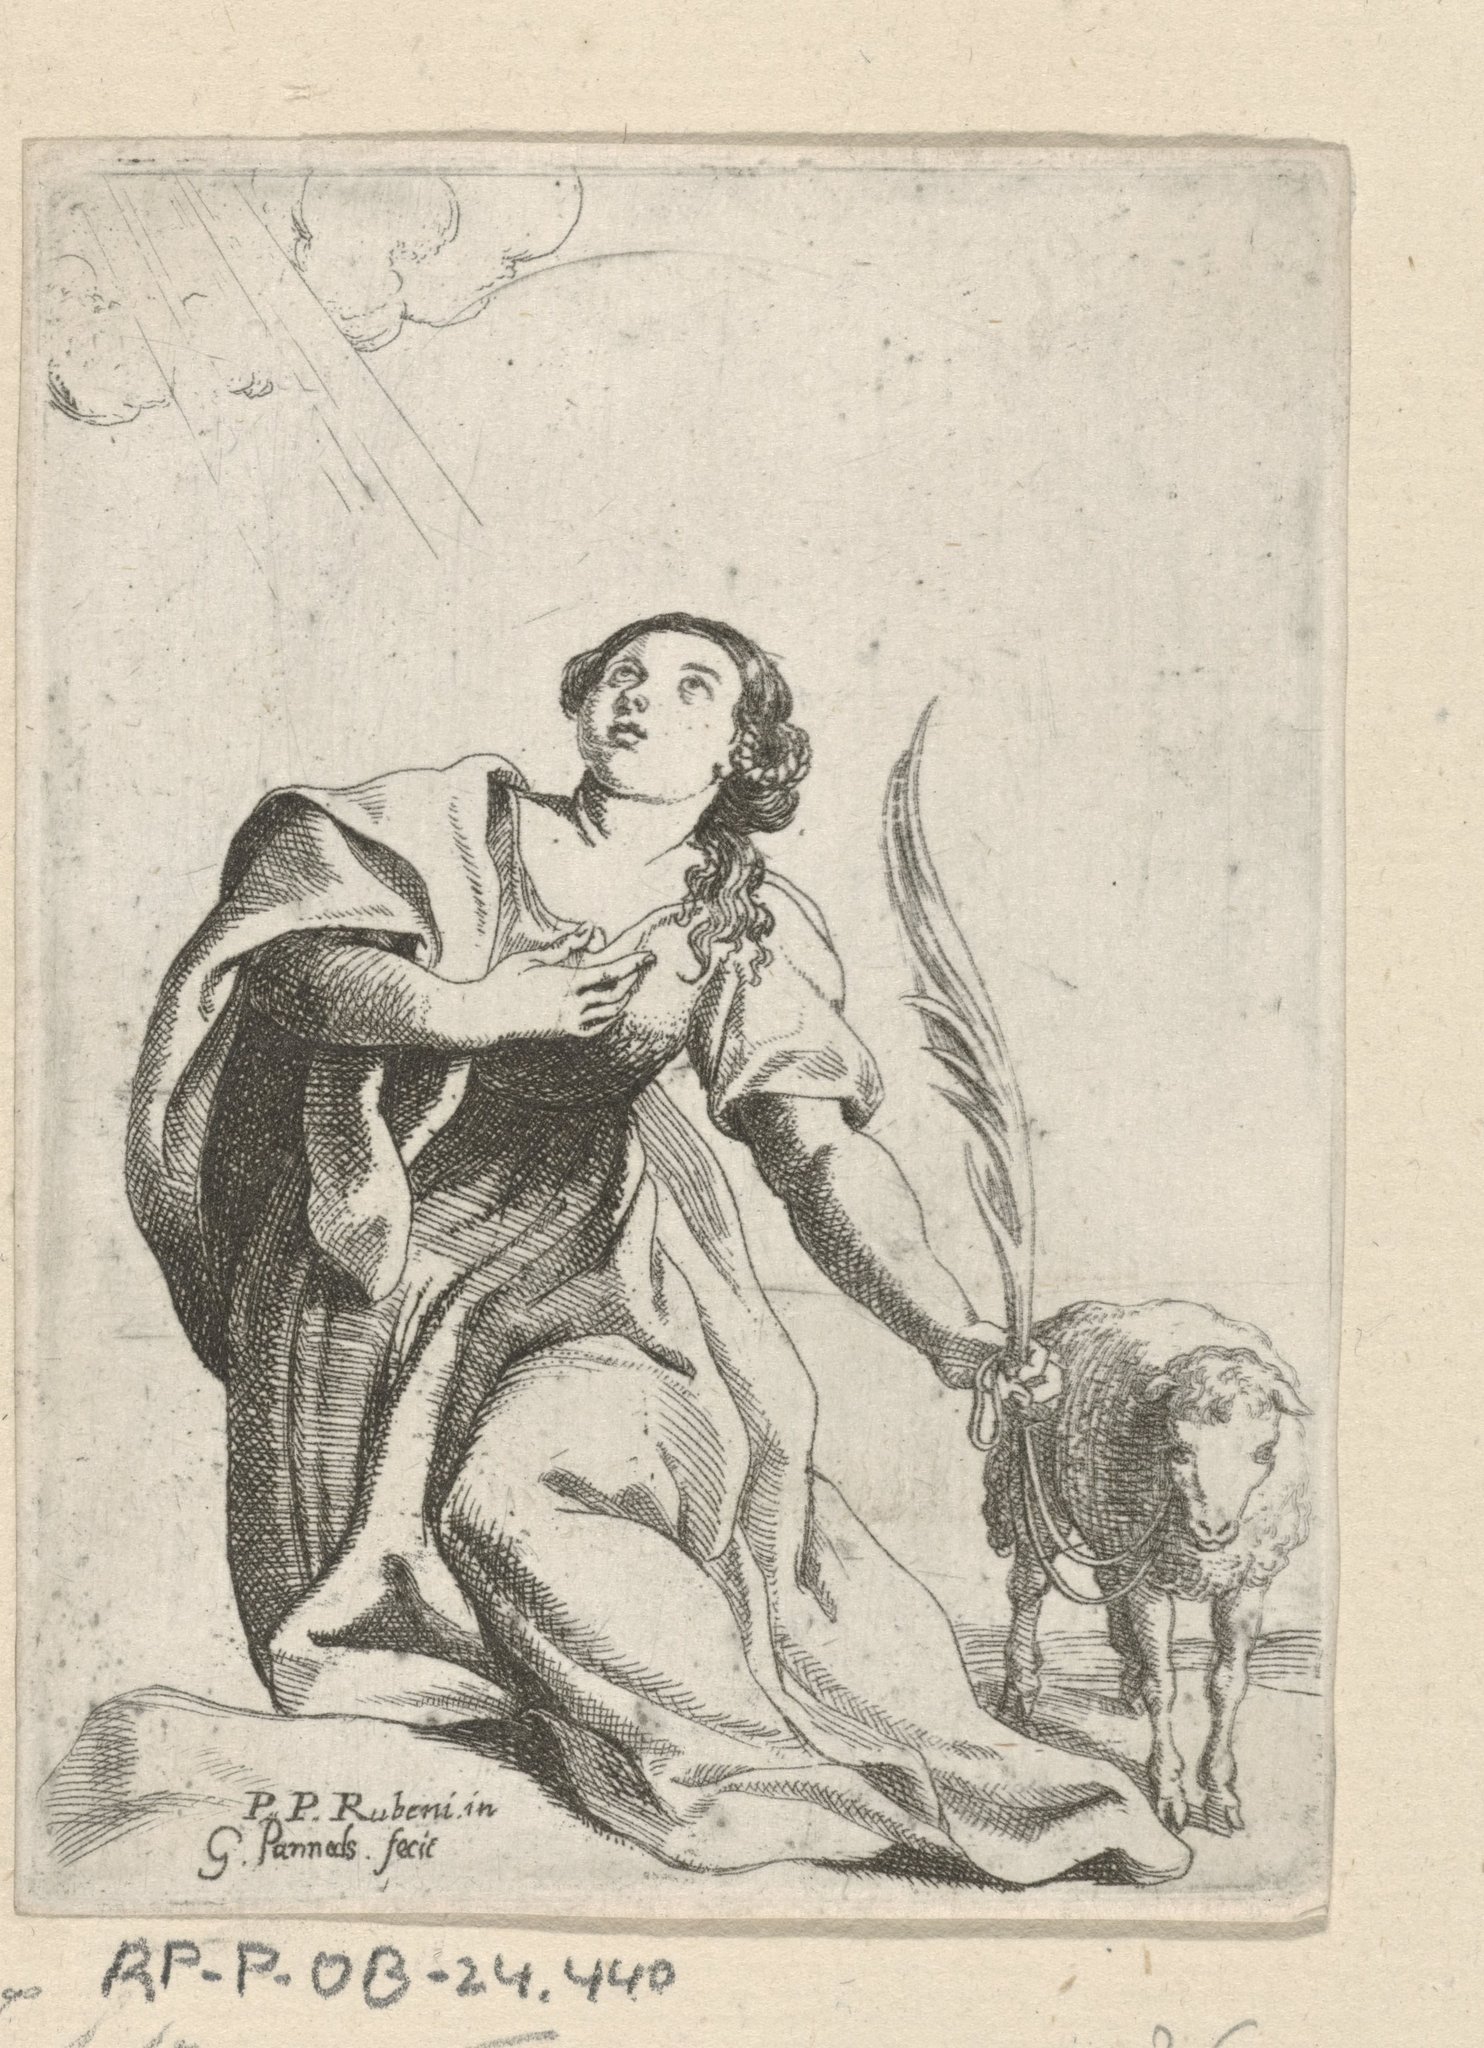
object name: print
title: H. Agnes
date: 1610-1634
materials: paper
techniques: engraving, etching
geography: antwerp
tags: the virgin martyr agnes of rome; possible attributes: lamb, ring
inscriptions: collector's mark: Lugt 240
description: De H. Agnes met palmtak en lam, opkijkend naar de hemel.